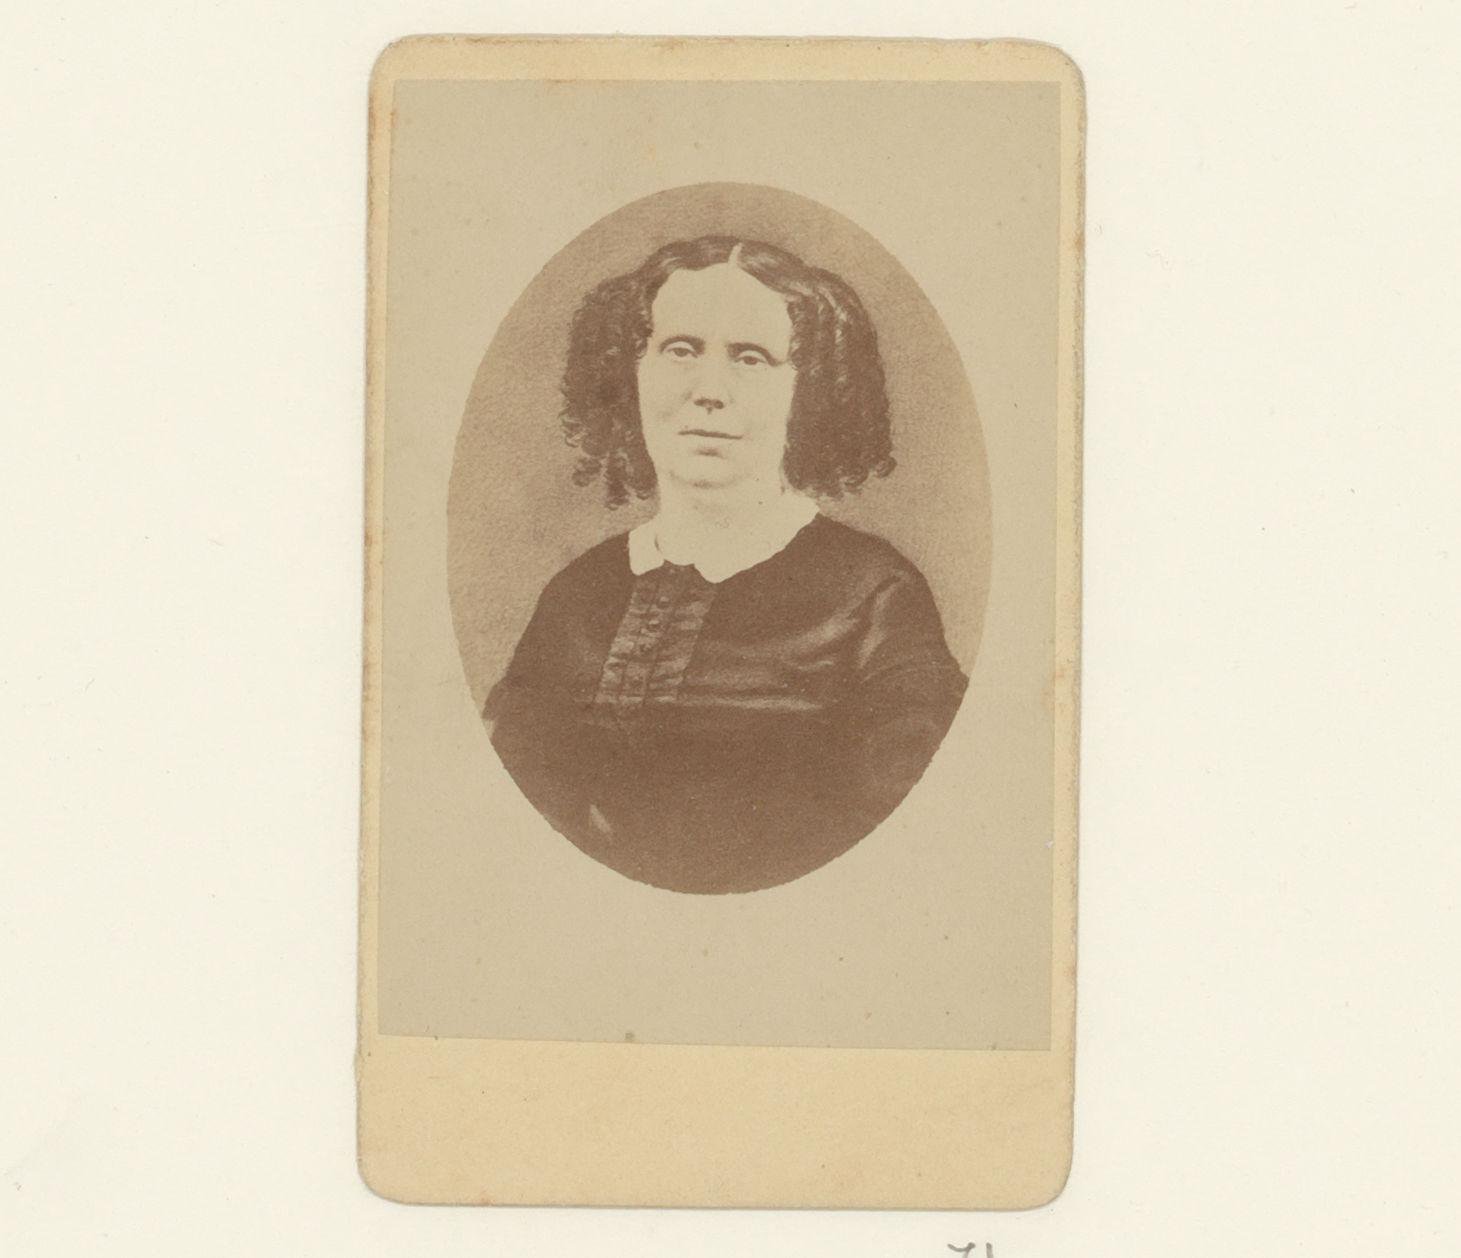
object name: photograph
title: Portret van Sophia Frederika Mathilda van Württemberg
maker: Anonymous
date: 1870-1880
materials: cardboard, paper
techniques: albumen print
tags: the hague, sophia frederika mathilda van württemberg, historical persons - bb - woman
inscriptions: collector's mark: Lugt 1641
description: Onderwerpsrubrieken binnen de Atlas Zeden en Gewoonten: Portretten, Portretten van Vorsten uit het huis van Oranje, Regeerende Vorsten, Koningen uit het huis van Oranje.